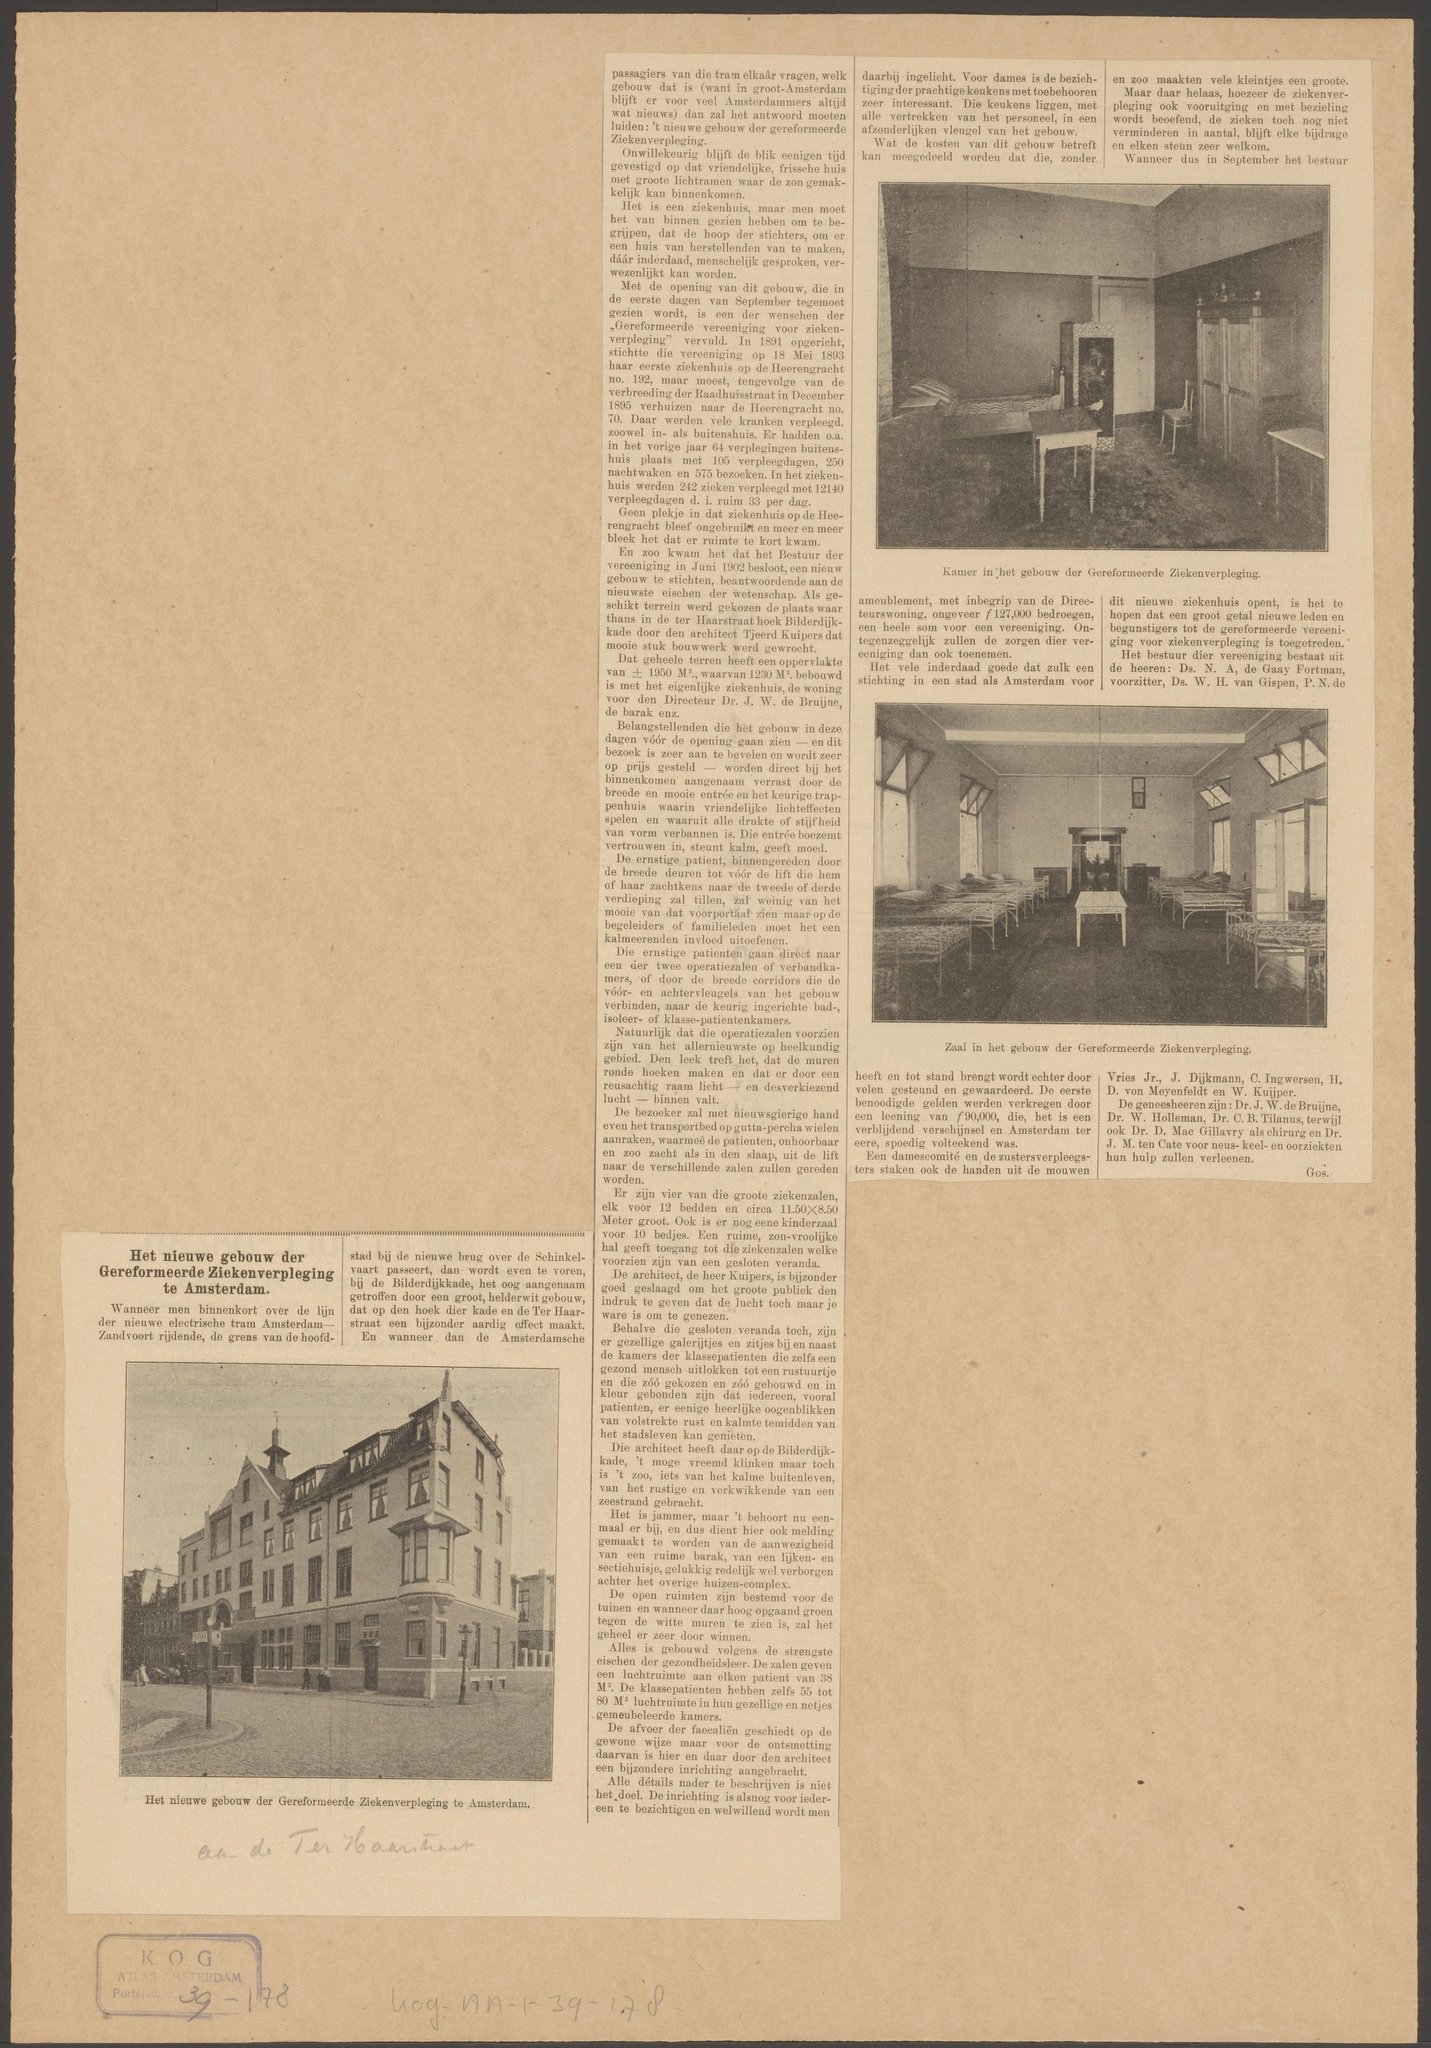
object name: article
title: Artikel over het ziekenhuis van de Gereformeerde Ziekenverpleging te Amsterdam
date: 1904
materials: paper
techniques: letterpress printing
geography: amsterdam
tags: hospital, ward; room (in hospital)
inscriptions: signature: ‘Gos.’, collector's mark: Lugt 1641b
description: Onderwerpsrubriek binnen de Atlas Amsterdam: Armwezen en liefdadige instellingen: V. Ziekenhuizen: Burgerziekenhuis - Boerhaavekliniek - Gasthuis der Ned. Ver. tegen Vallende Ziekte - Diaconessenhuis Keizersgracht - Diaconessenhuis Overtoom - Gereformeerde Ziekenverpleging.